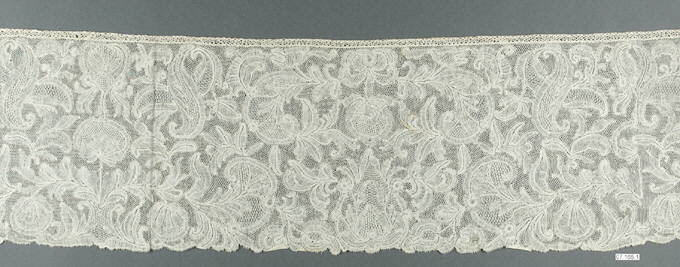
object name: piece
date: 1701-1800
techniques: lace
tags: flowers,leaves